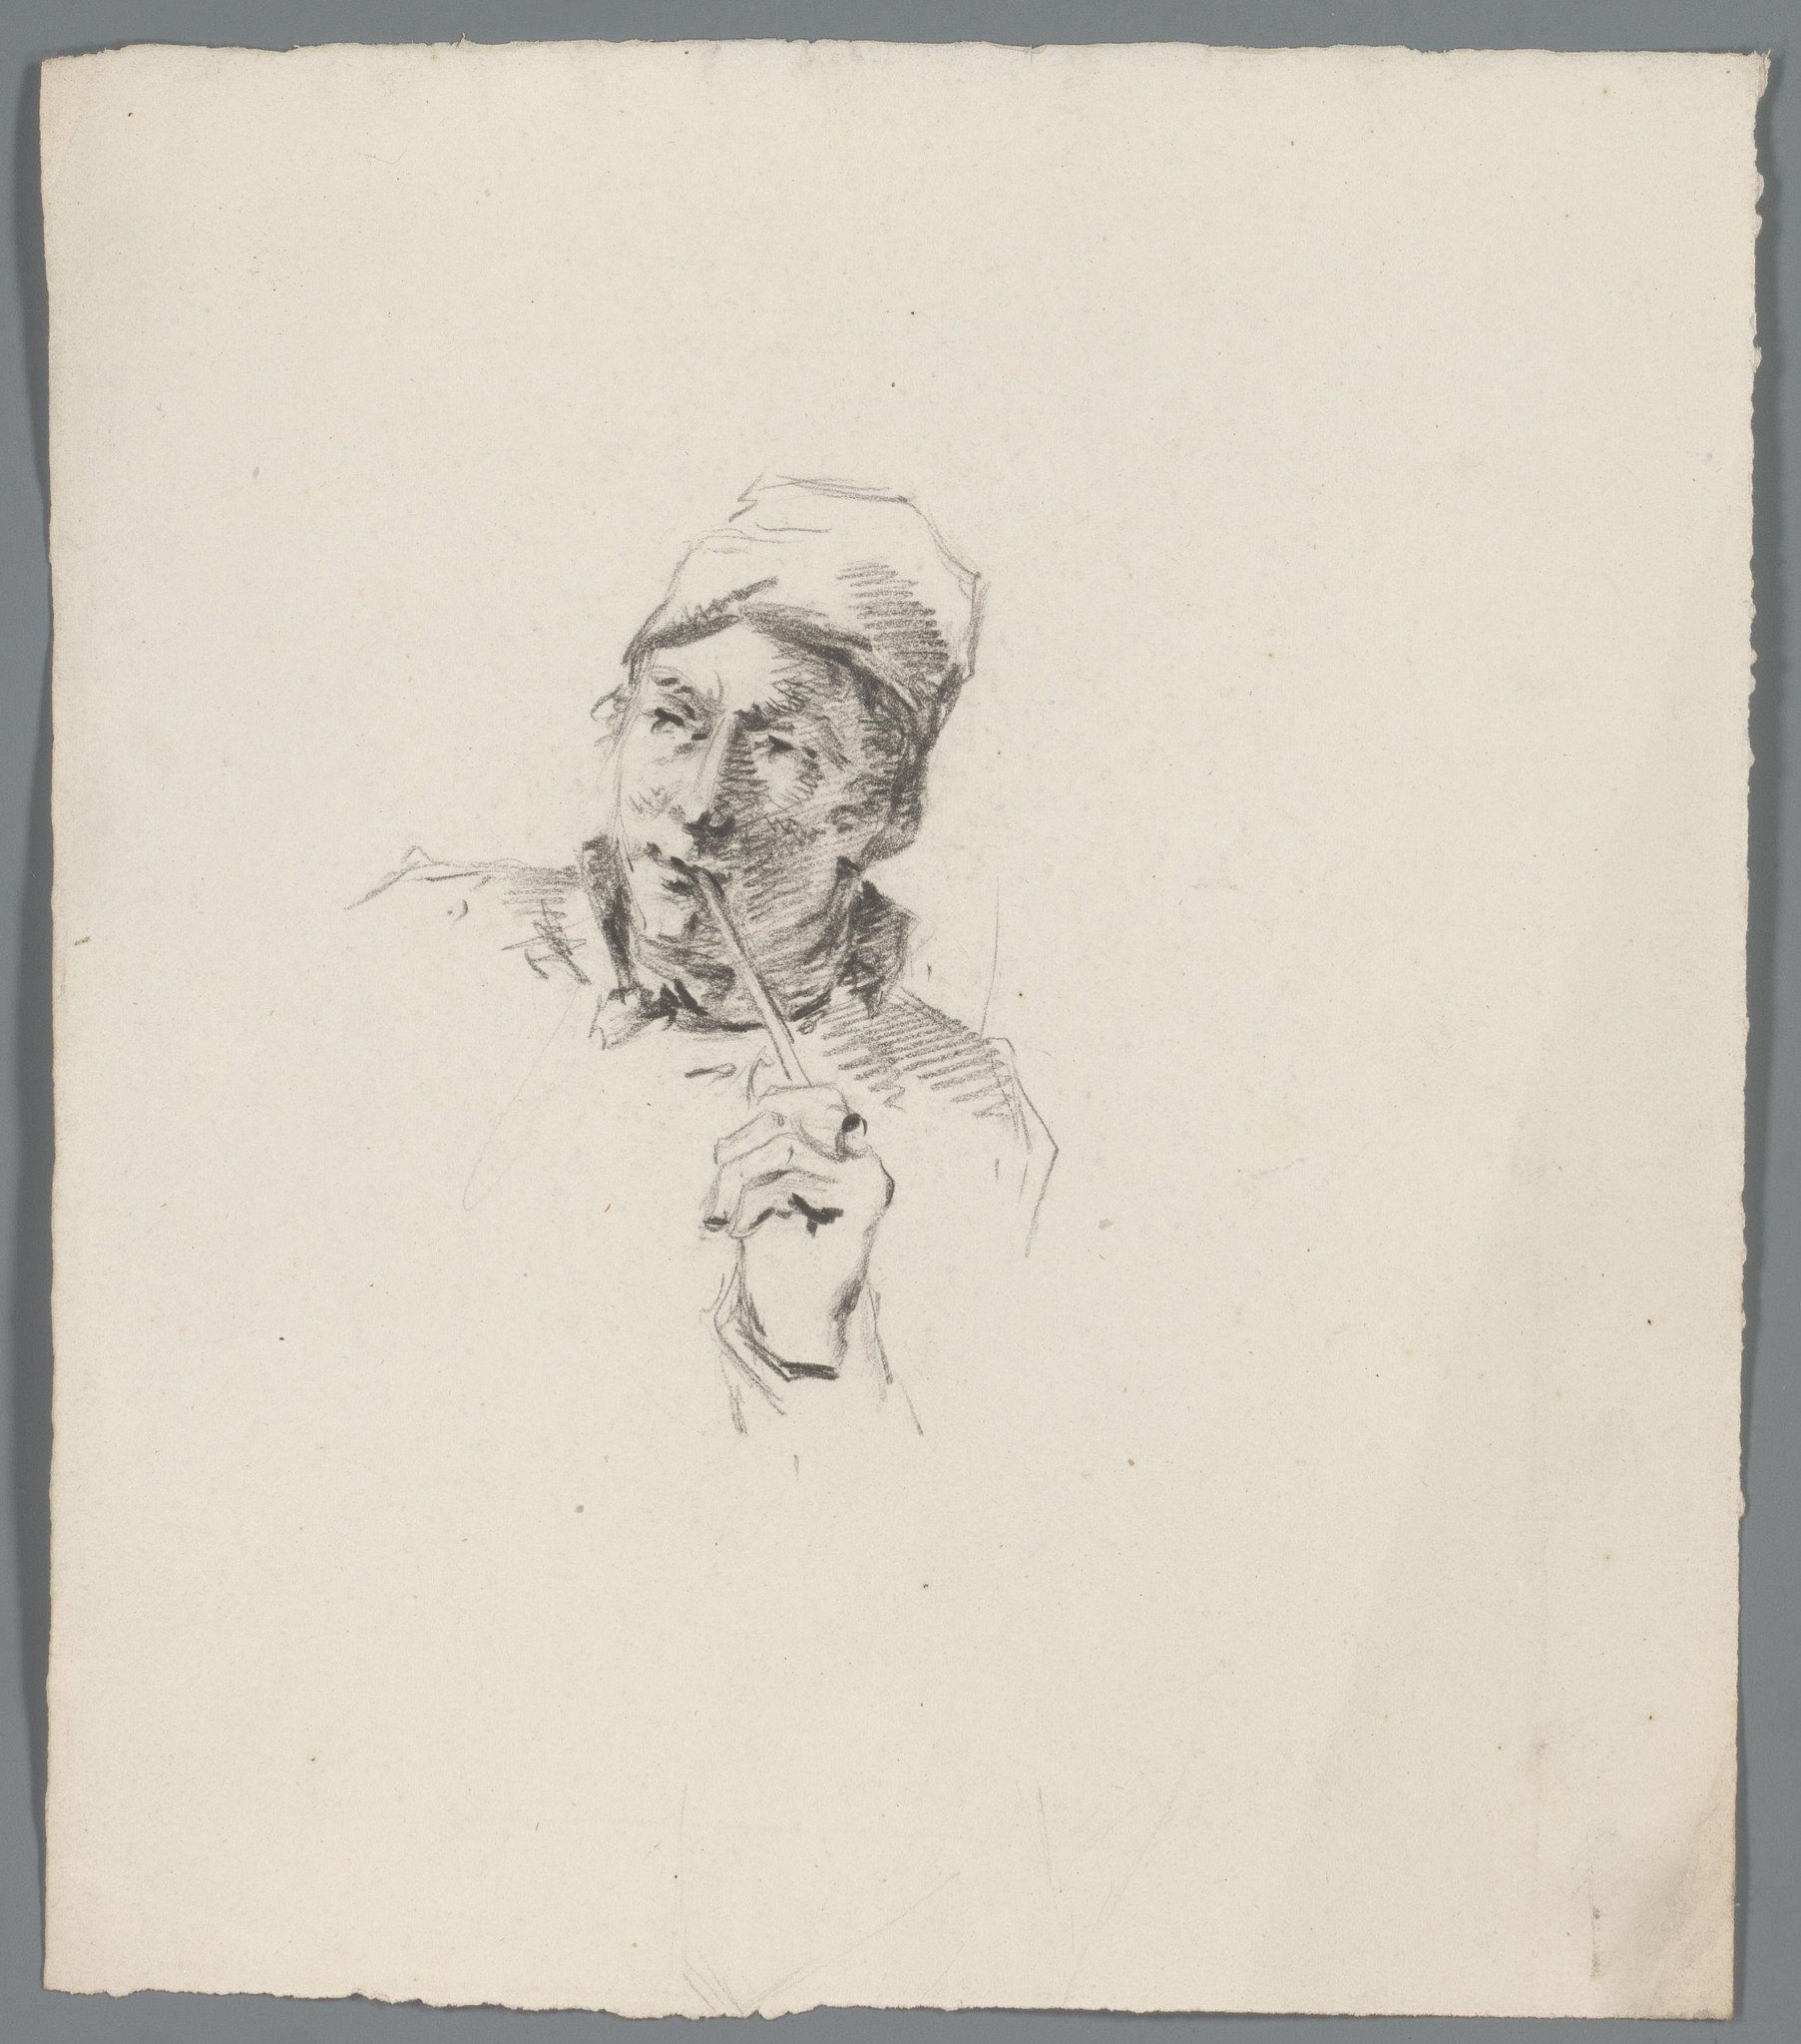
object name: drawing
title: Pijprokende man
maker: Anonymous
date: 1820-1830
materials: chalk, paper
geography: the hague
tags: adult man, pipe ~ tobacco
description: Tekeningen waarschijnlijk ontstaan bij het Haagse kunstgenootschap ‘Tot Nut der Tekenkunst’, waar twee keer per week tekenavonden werden georganiseerd met geklede modellen.